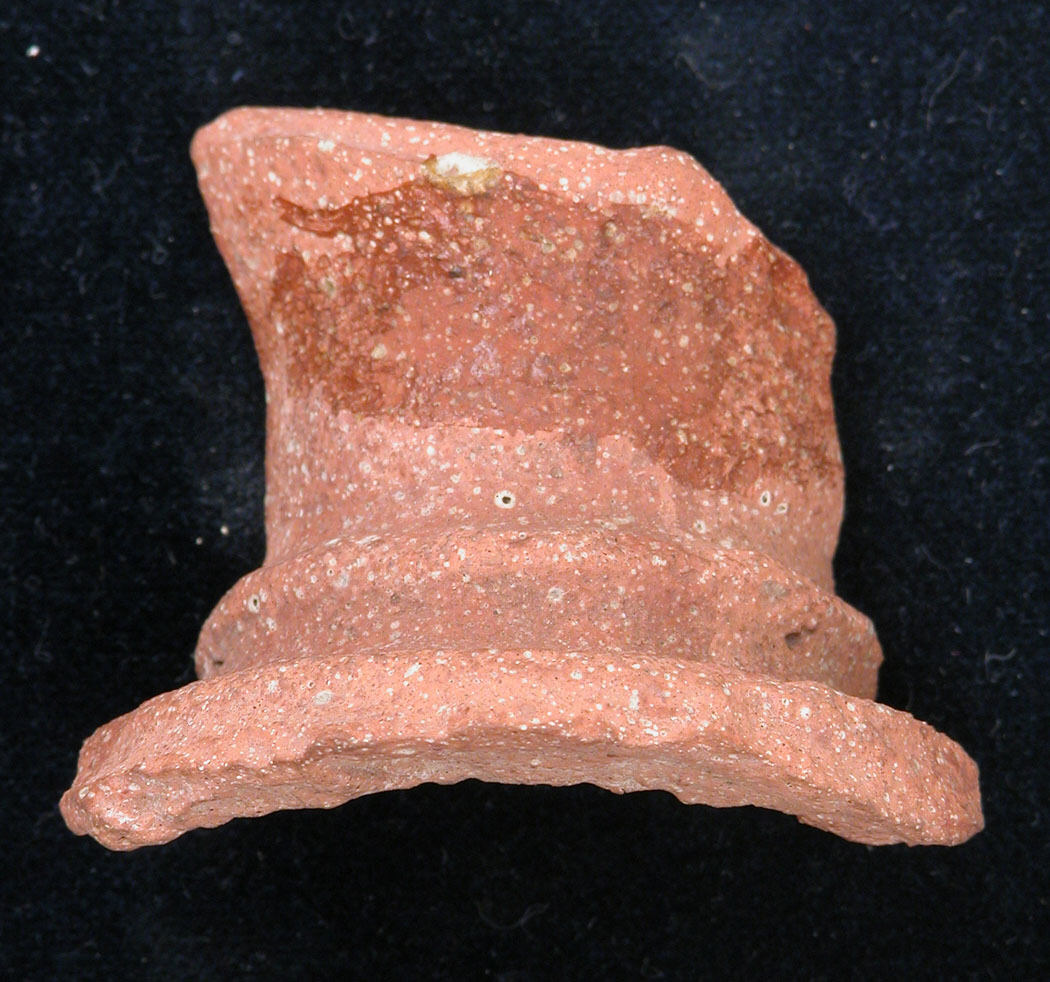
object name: fragment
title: Ceramic Fragment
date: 801-1000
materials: earthenware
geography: saudi arabia